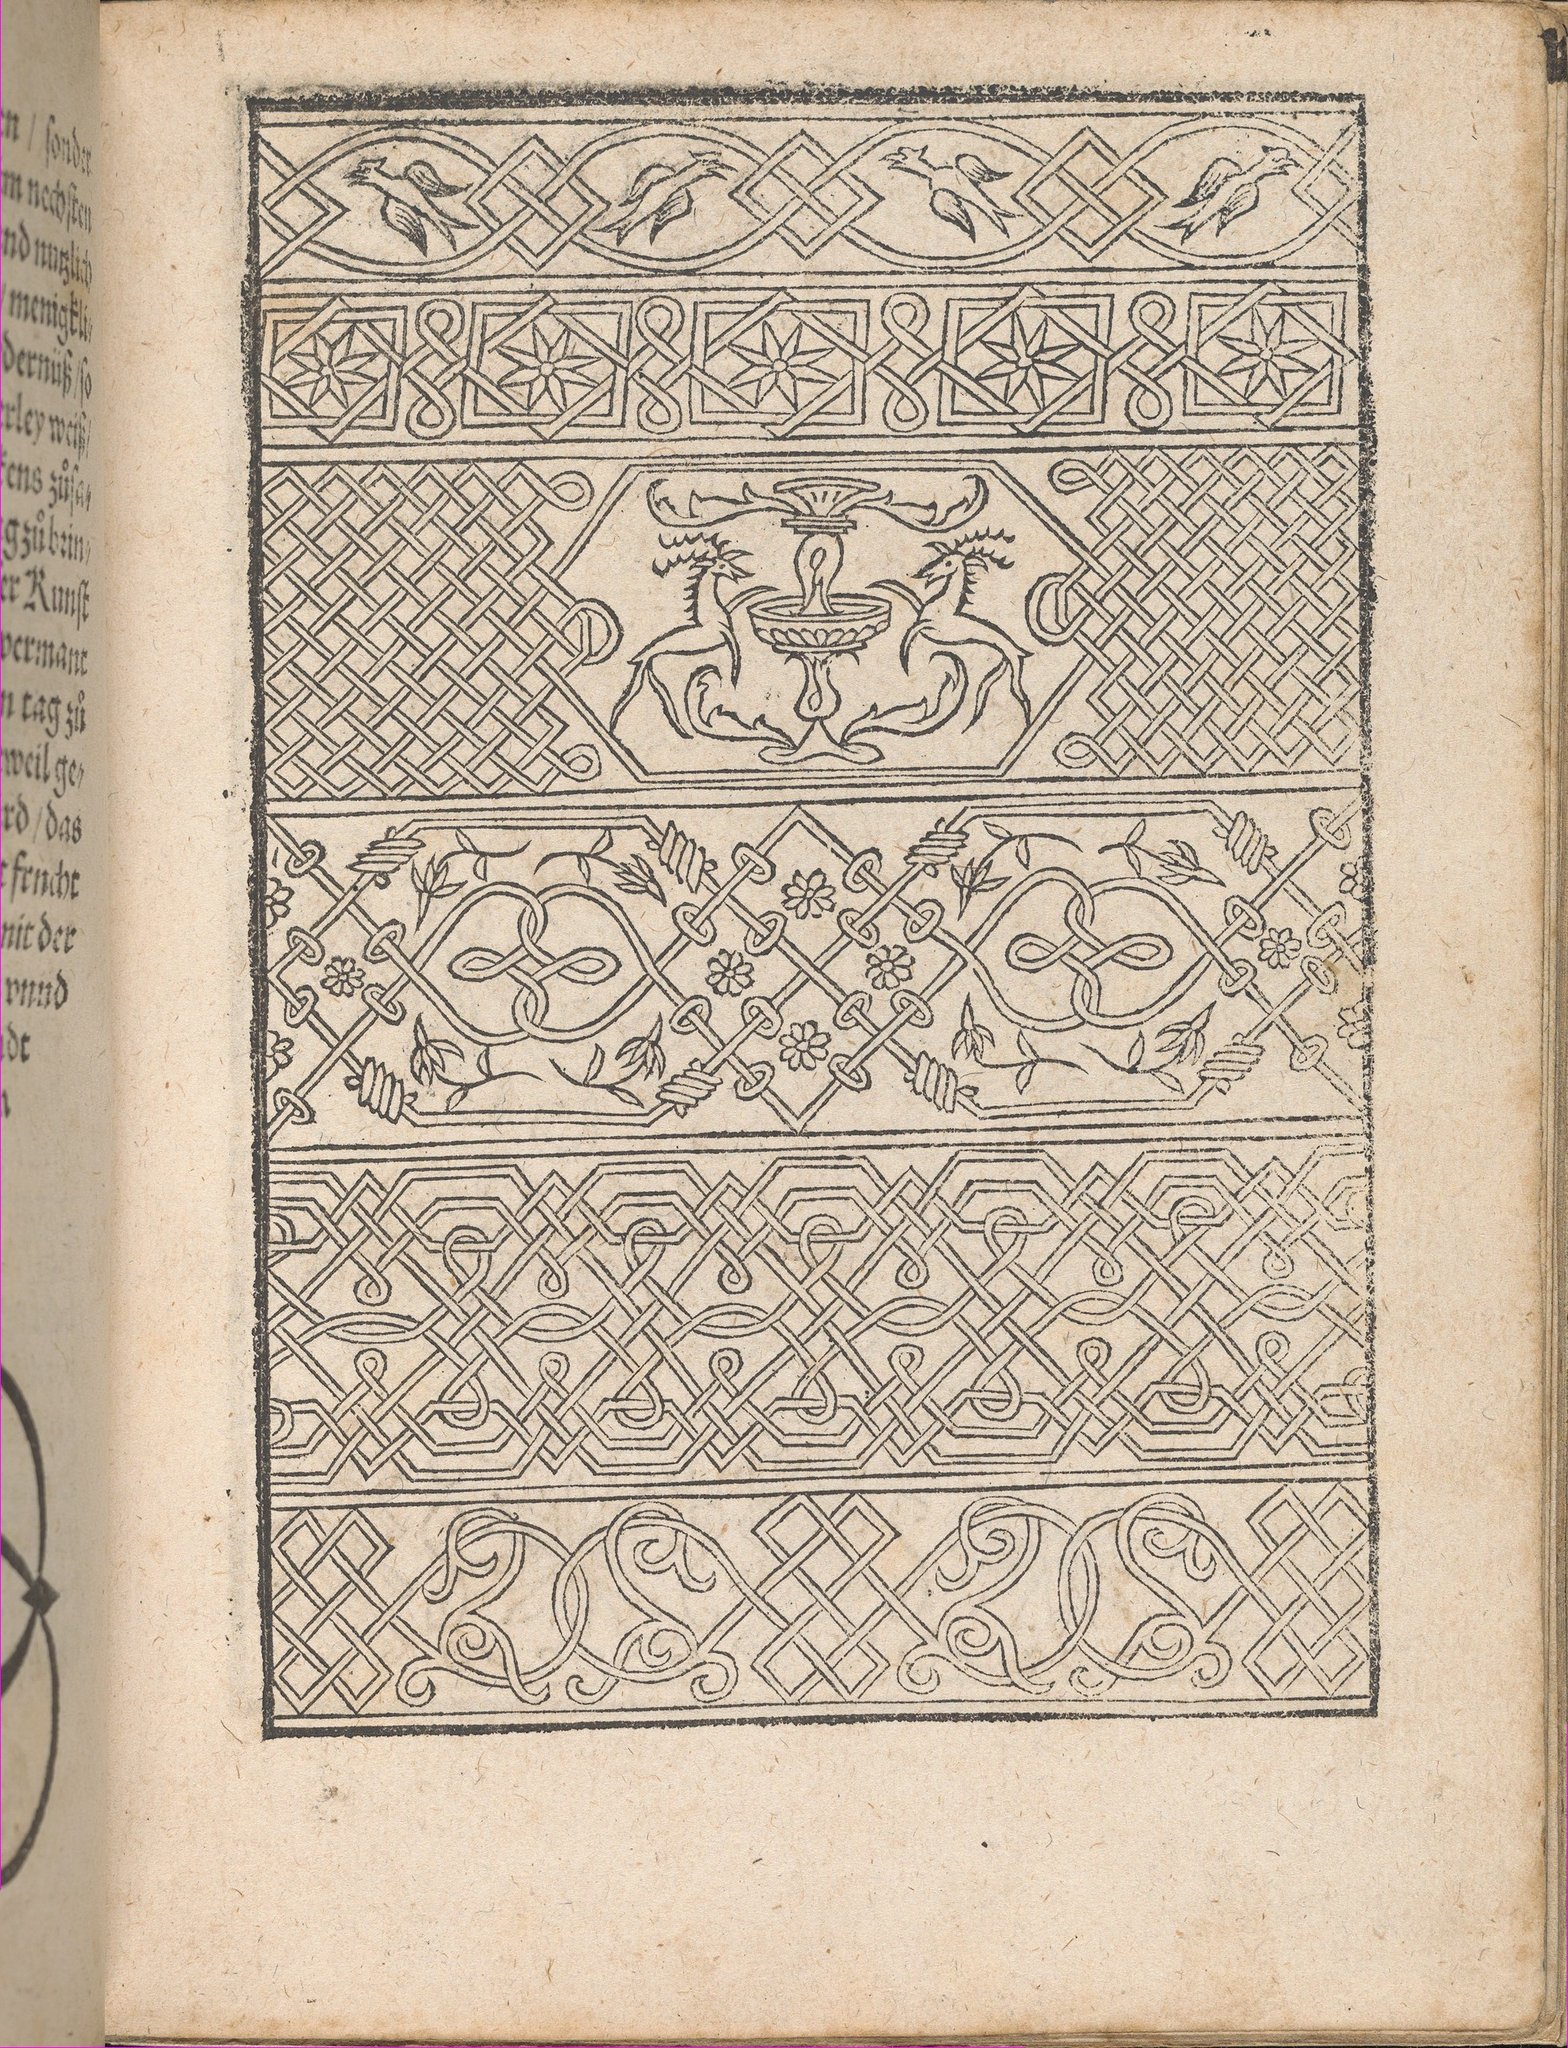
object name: book print ornament architecture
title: New Modelbüch allen Nägerin u. Sydenstickern (Page 3r)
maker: hans hoffman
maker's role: designer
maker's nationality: german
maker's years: 1556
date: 1556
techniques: woodcut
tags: ornament